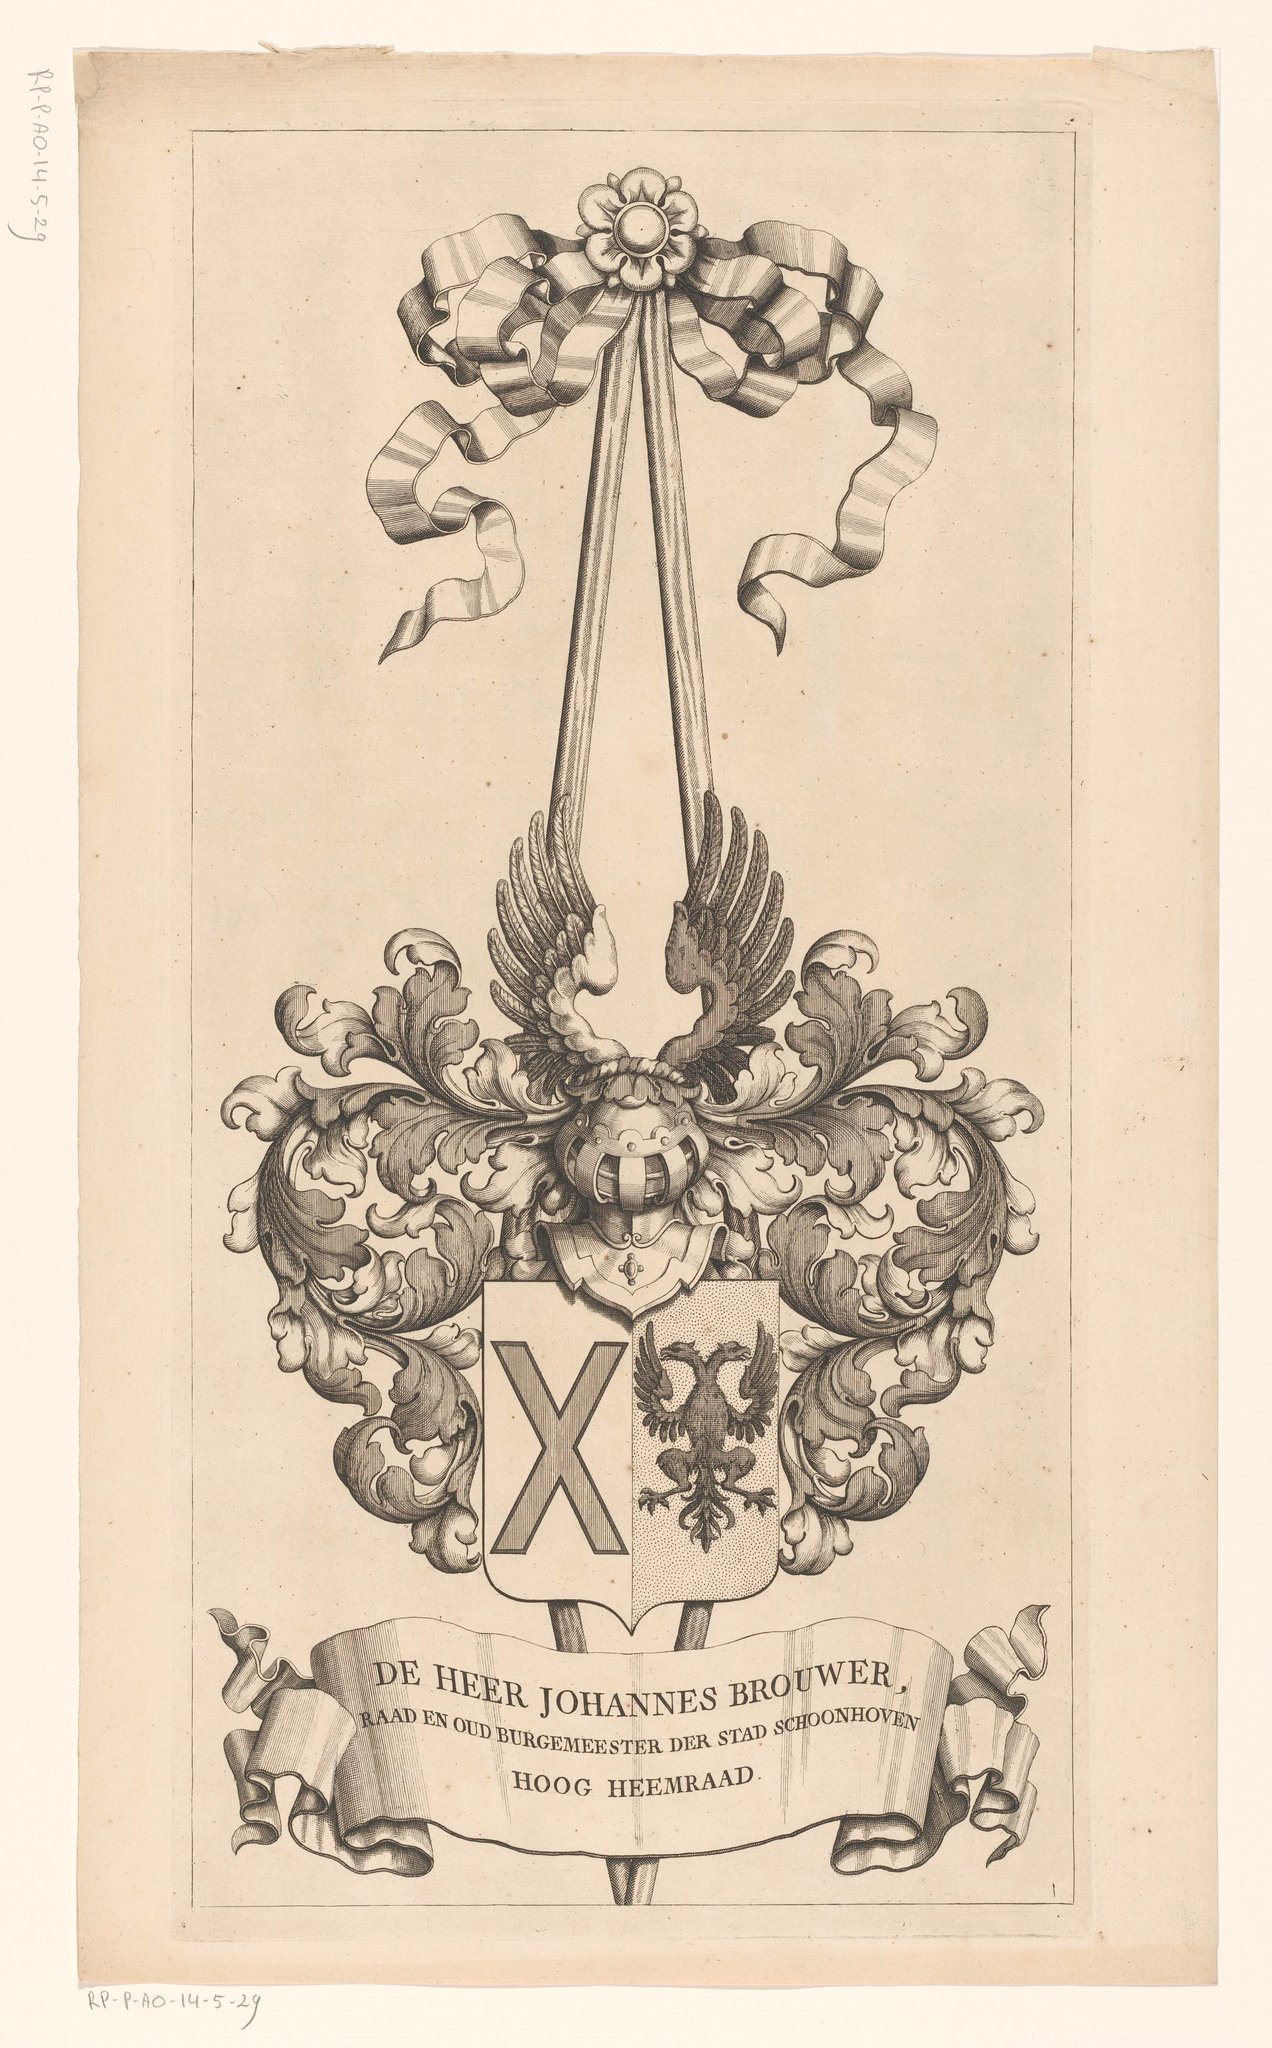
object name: print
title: Kaart van het Hoogheemraadschap van de Krimpenerwaard (deel wapenrand)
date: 1683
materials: paper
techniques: engraving, etching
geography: amsterdam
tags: armorial bearing, heraldry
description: Deel van de wapenrand van de vijfde druk van 'Het Hooge Heemraadschap van de Crimpenre Waard', een wandkaart (bestaande uit een kaart en een wapenrand) van het Hoogheemraadschap van de Krimpenerwaard.